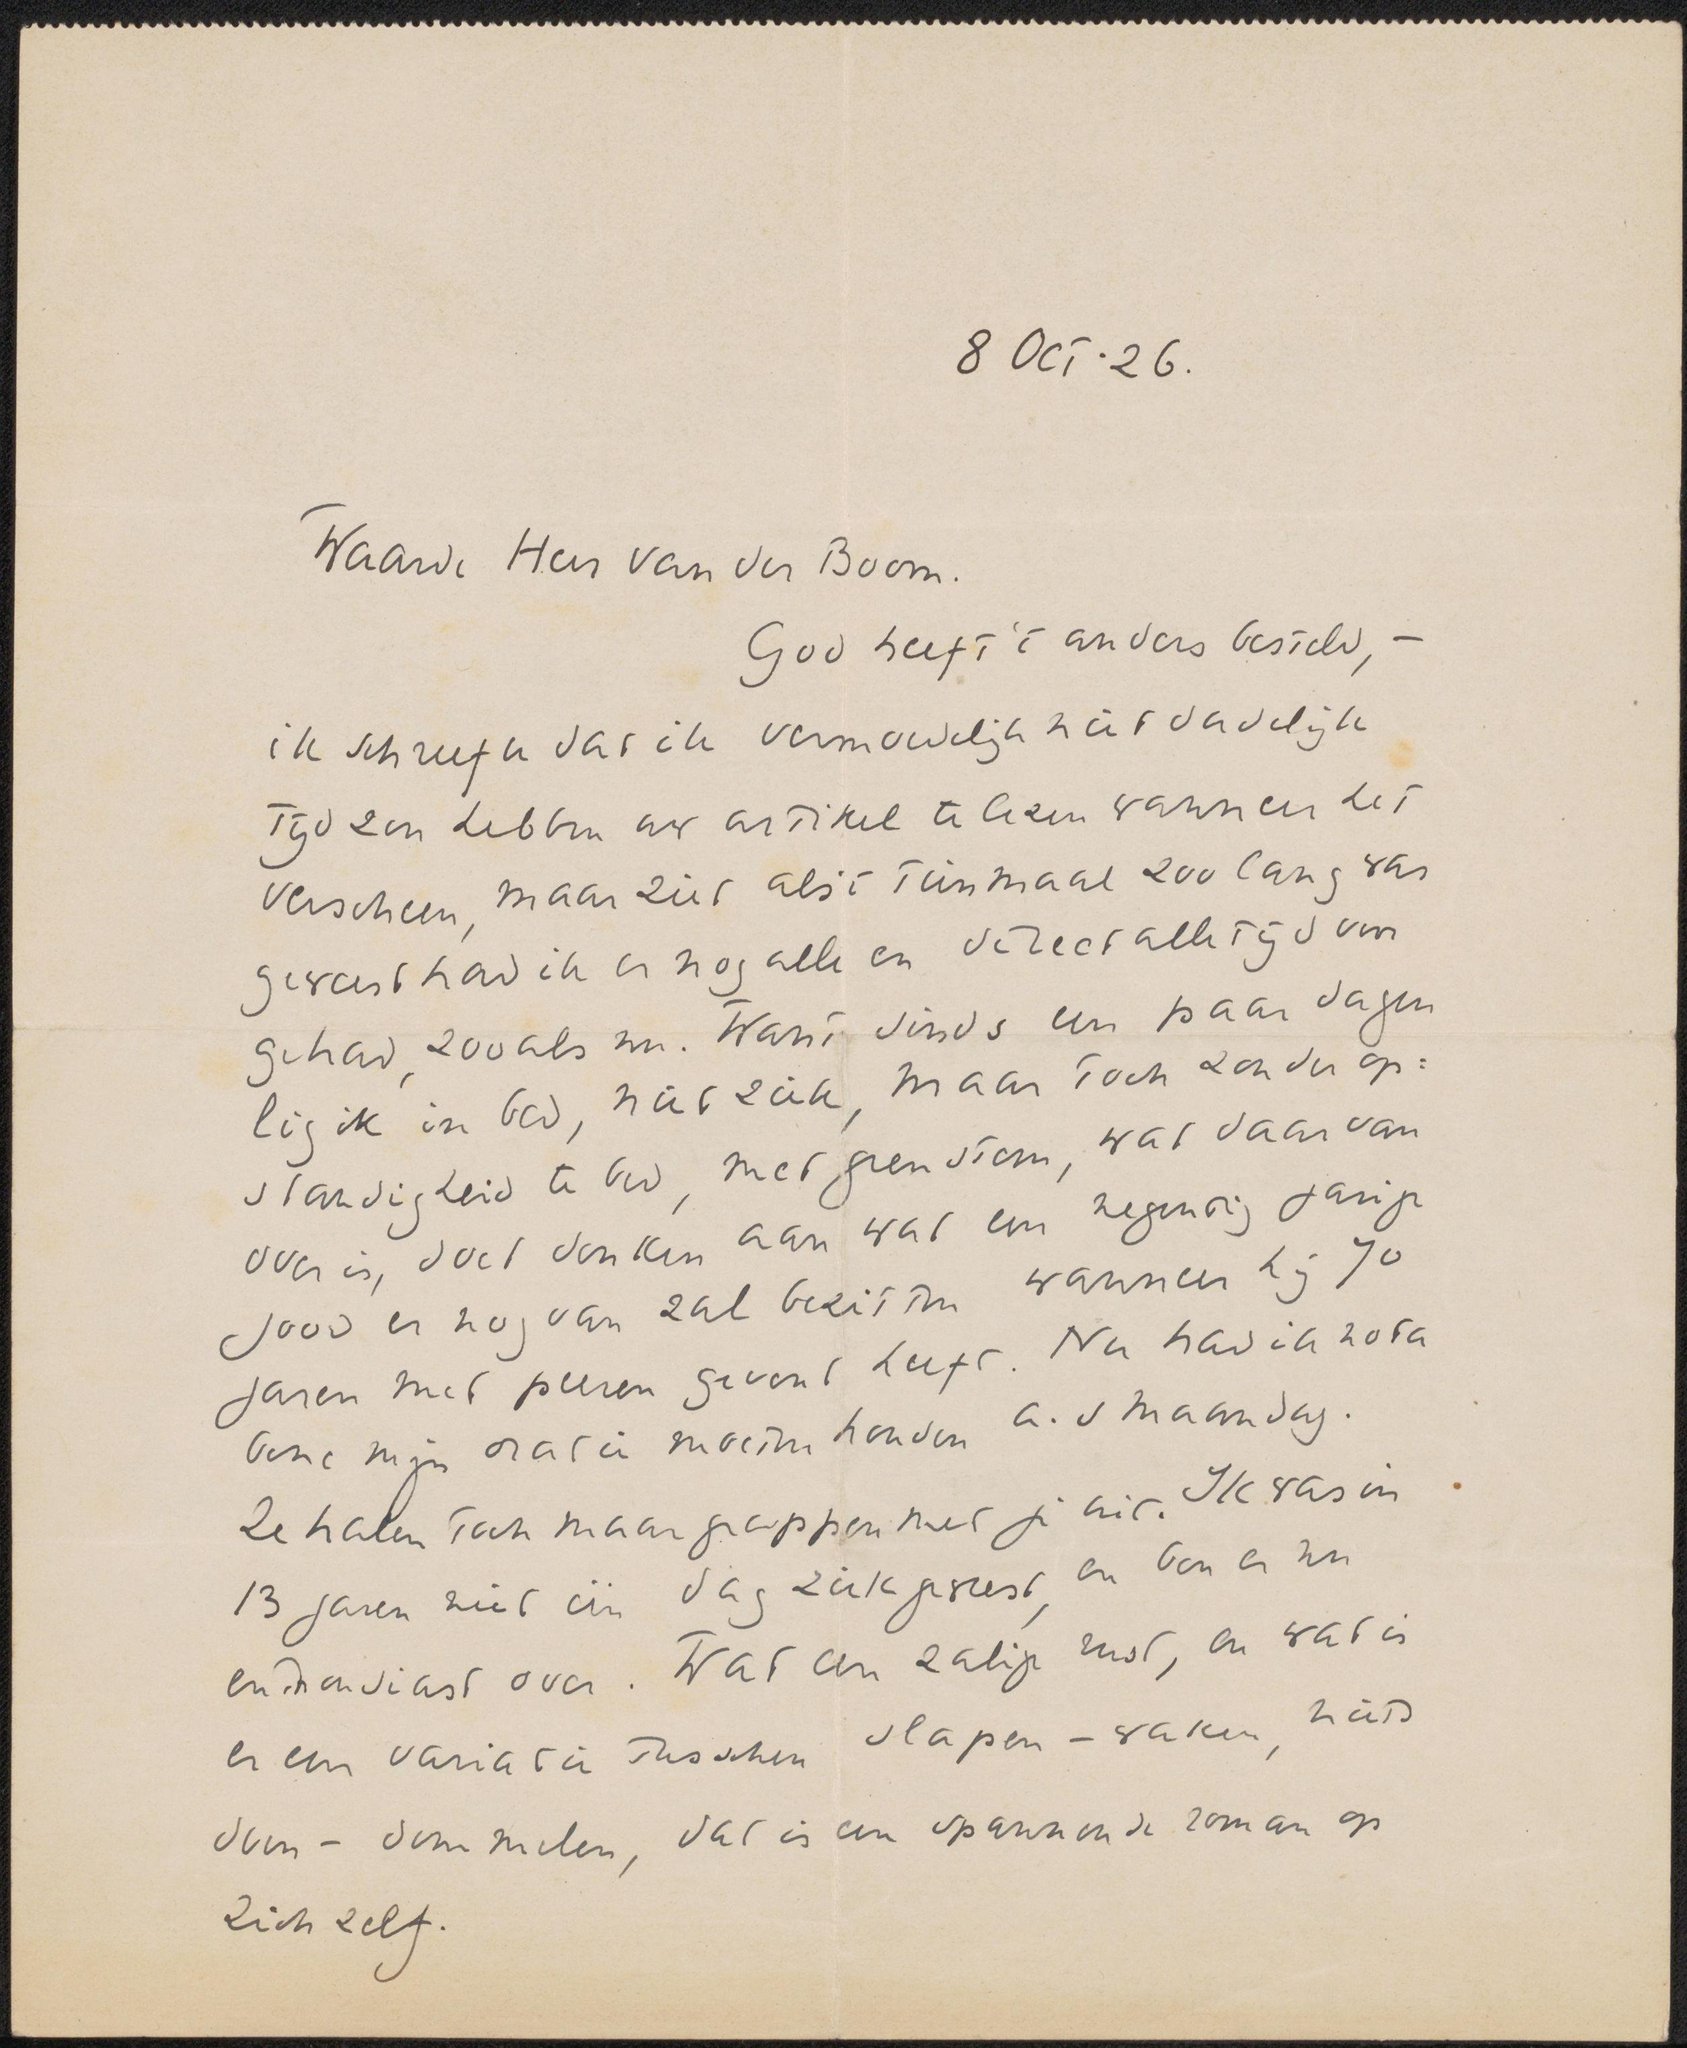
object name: letter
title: Brief aan A. van der Boom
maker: richard nicolaüs roland holst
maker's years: 1868-1938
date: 1926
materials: ink, paper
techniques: pen, writing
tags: a. van der boom, diseases, printed matter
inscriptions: collector's mark: Lugt L.2228a